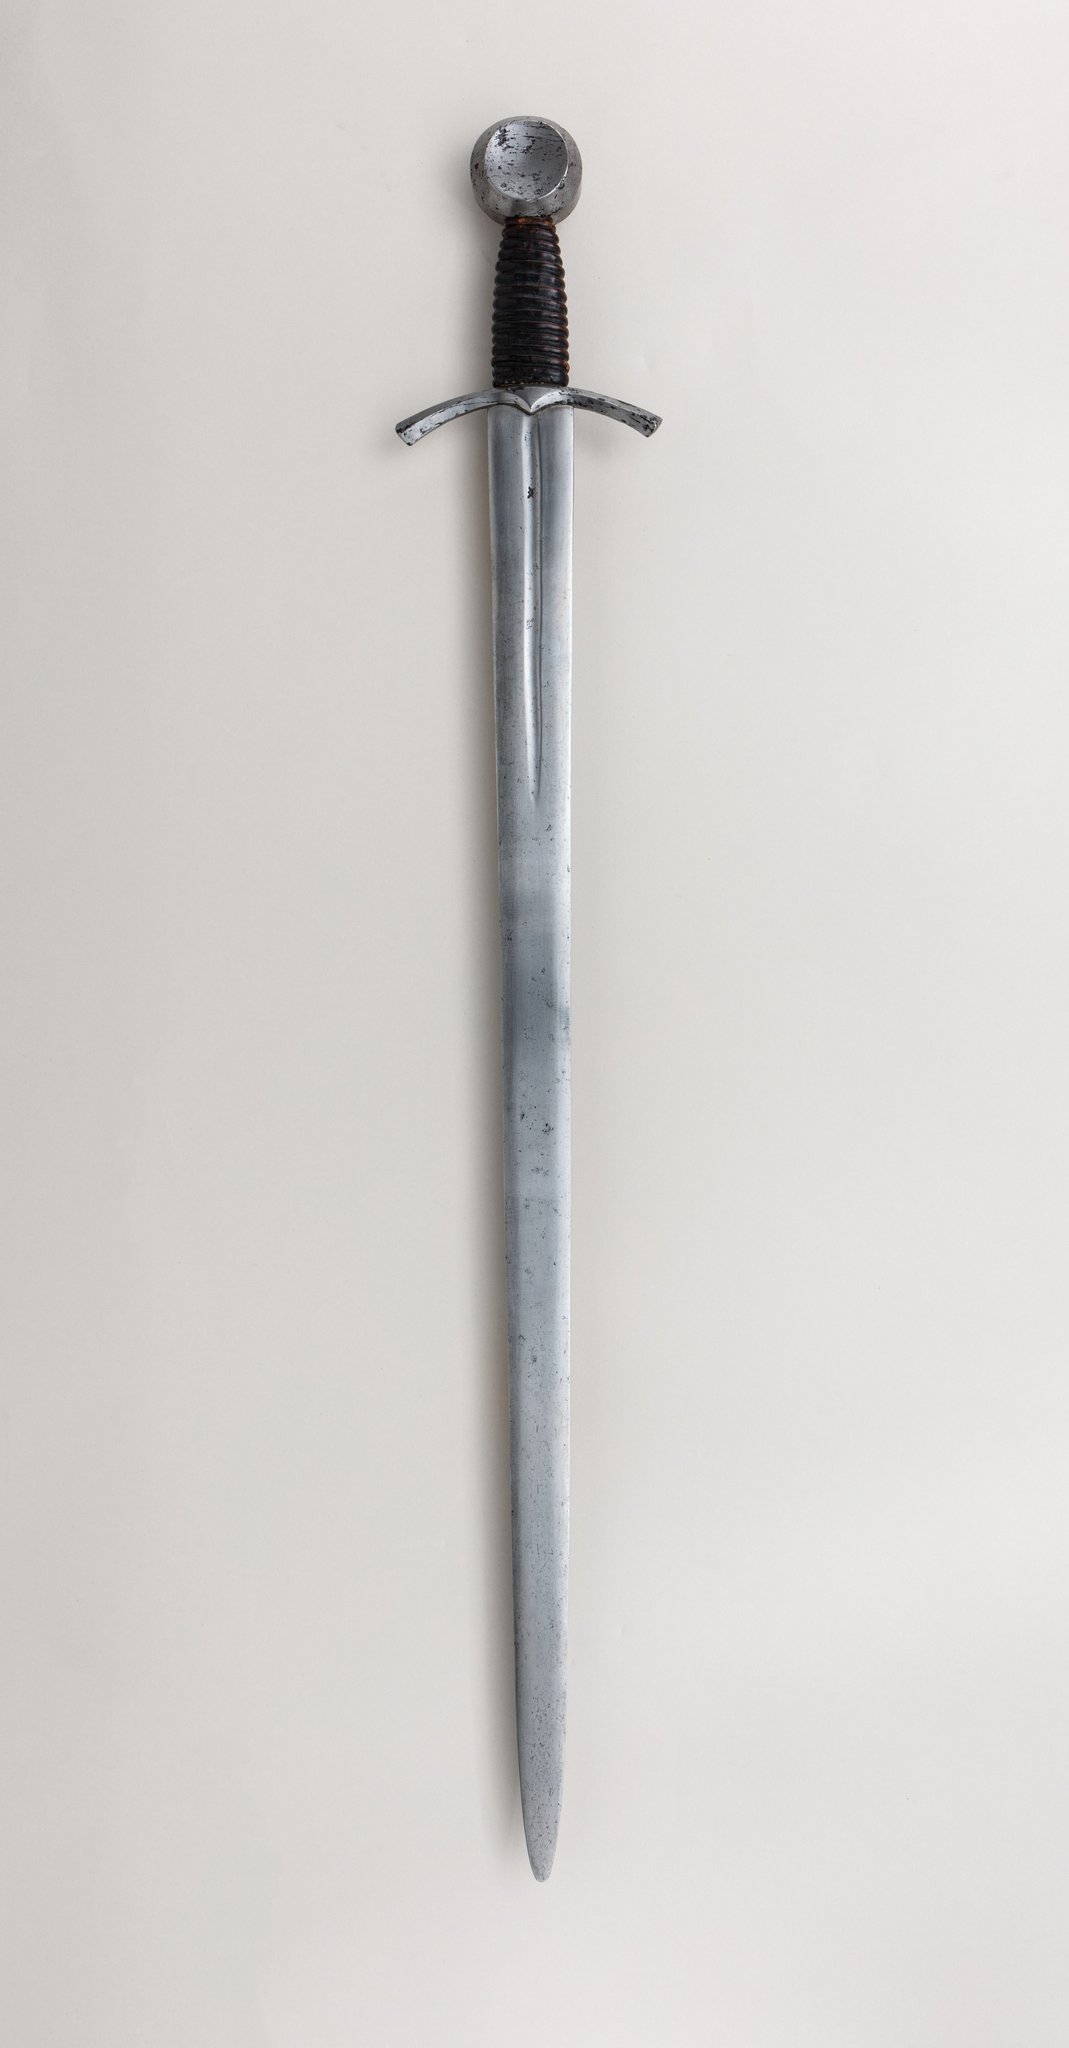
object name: sword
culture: european, western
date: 1450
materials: copper, leather, steel, wood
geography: italy